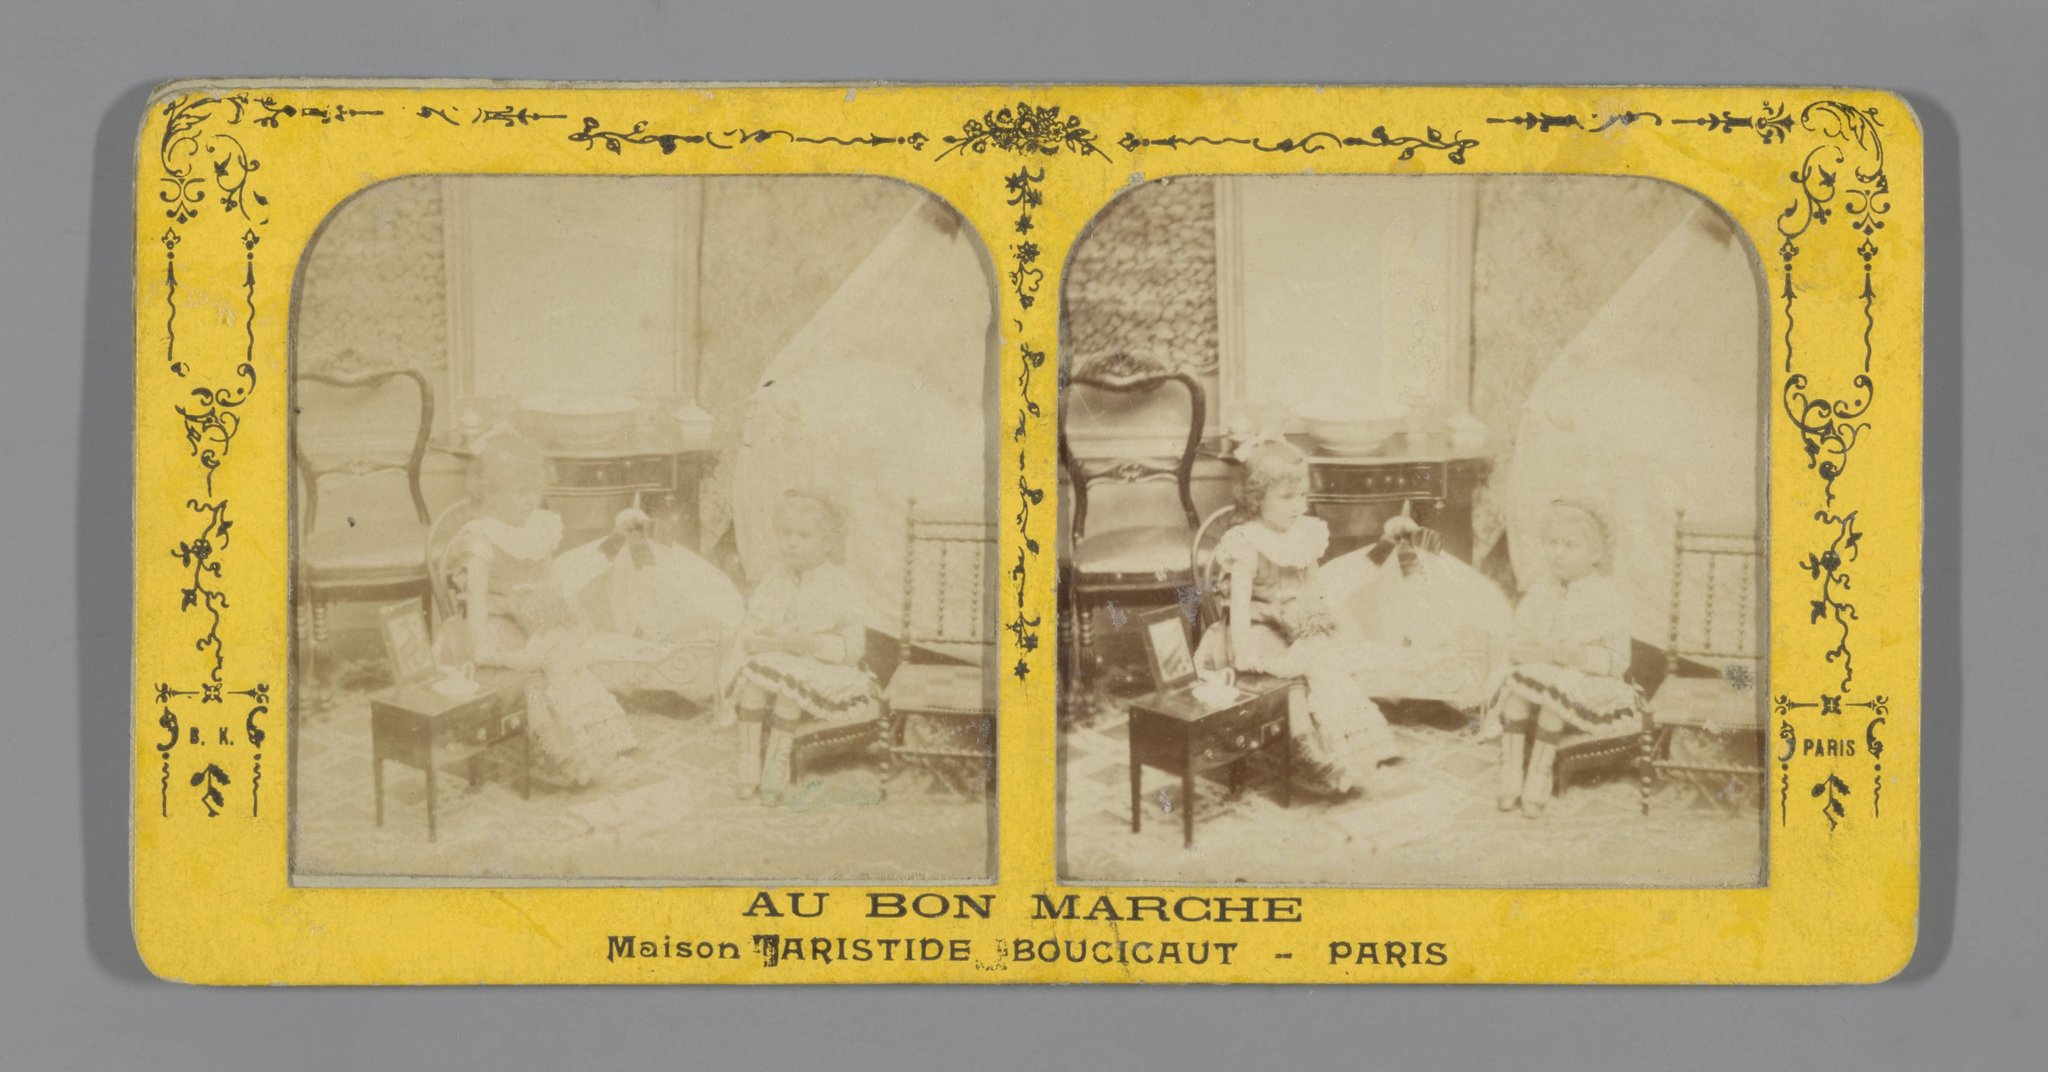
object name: tissue stereograph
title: Petite mère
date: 1863-1875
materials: cardboard, paper, photographic support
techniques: albumen print, hand coloring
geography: paris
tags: children's games and plays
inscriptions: number: ‘8’, retailer's mark: ‘AU BON MARCHE/ Maison ARTISTIDE BOUCICAUT - PARIS’